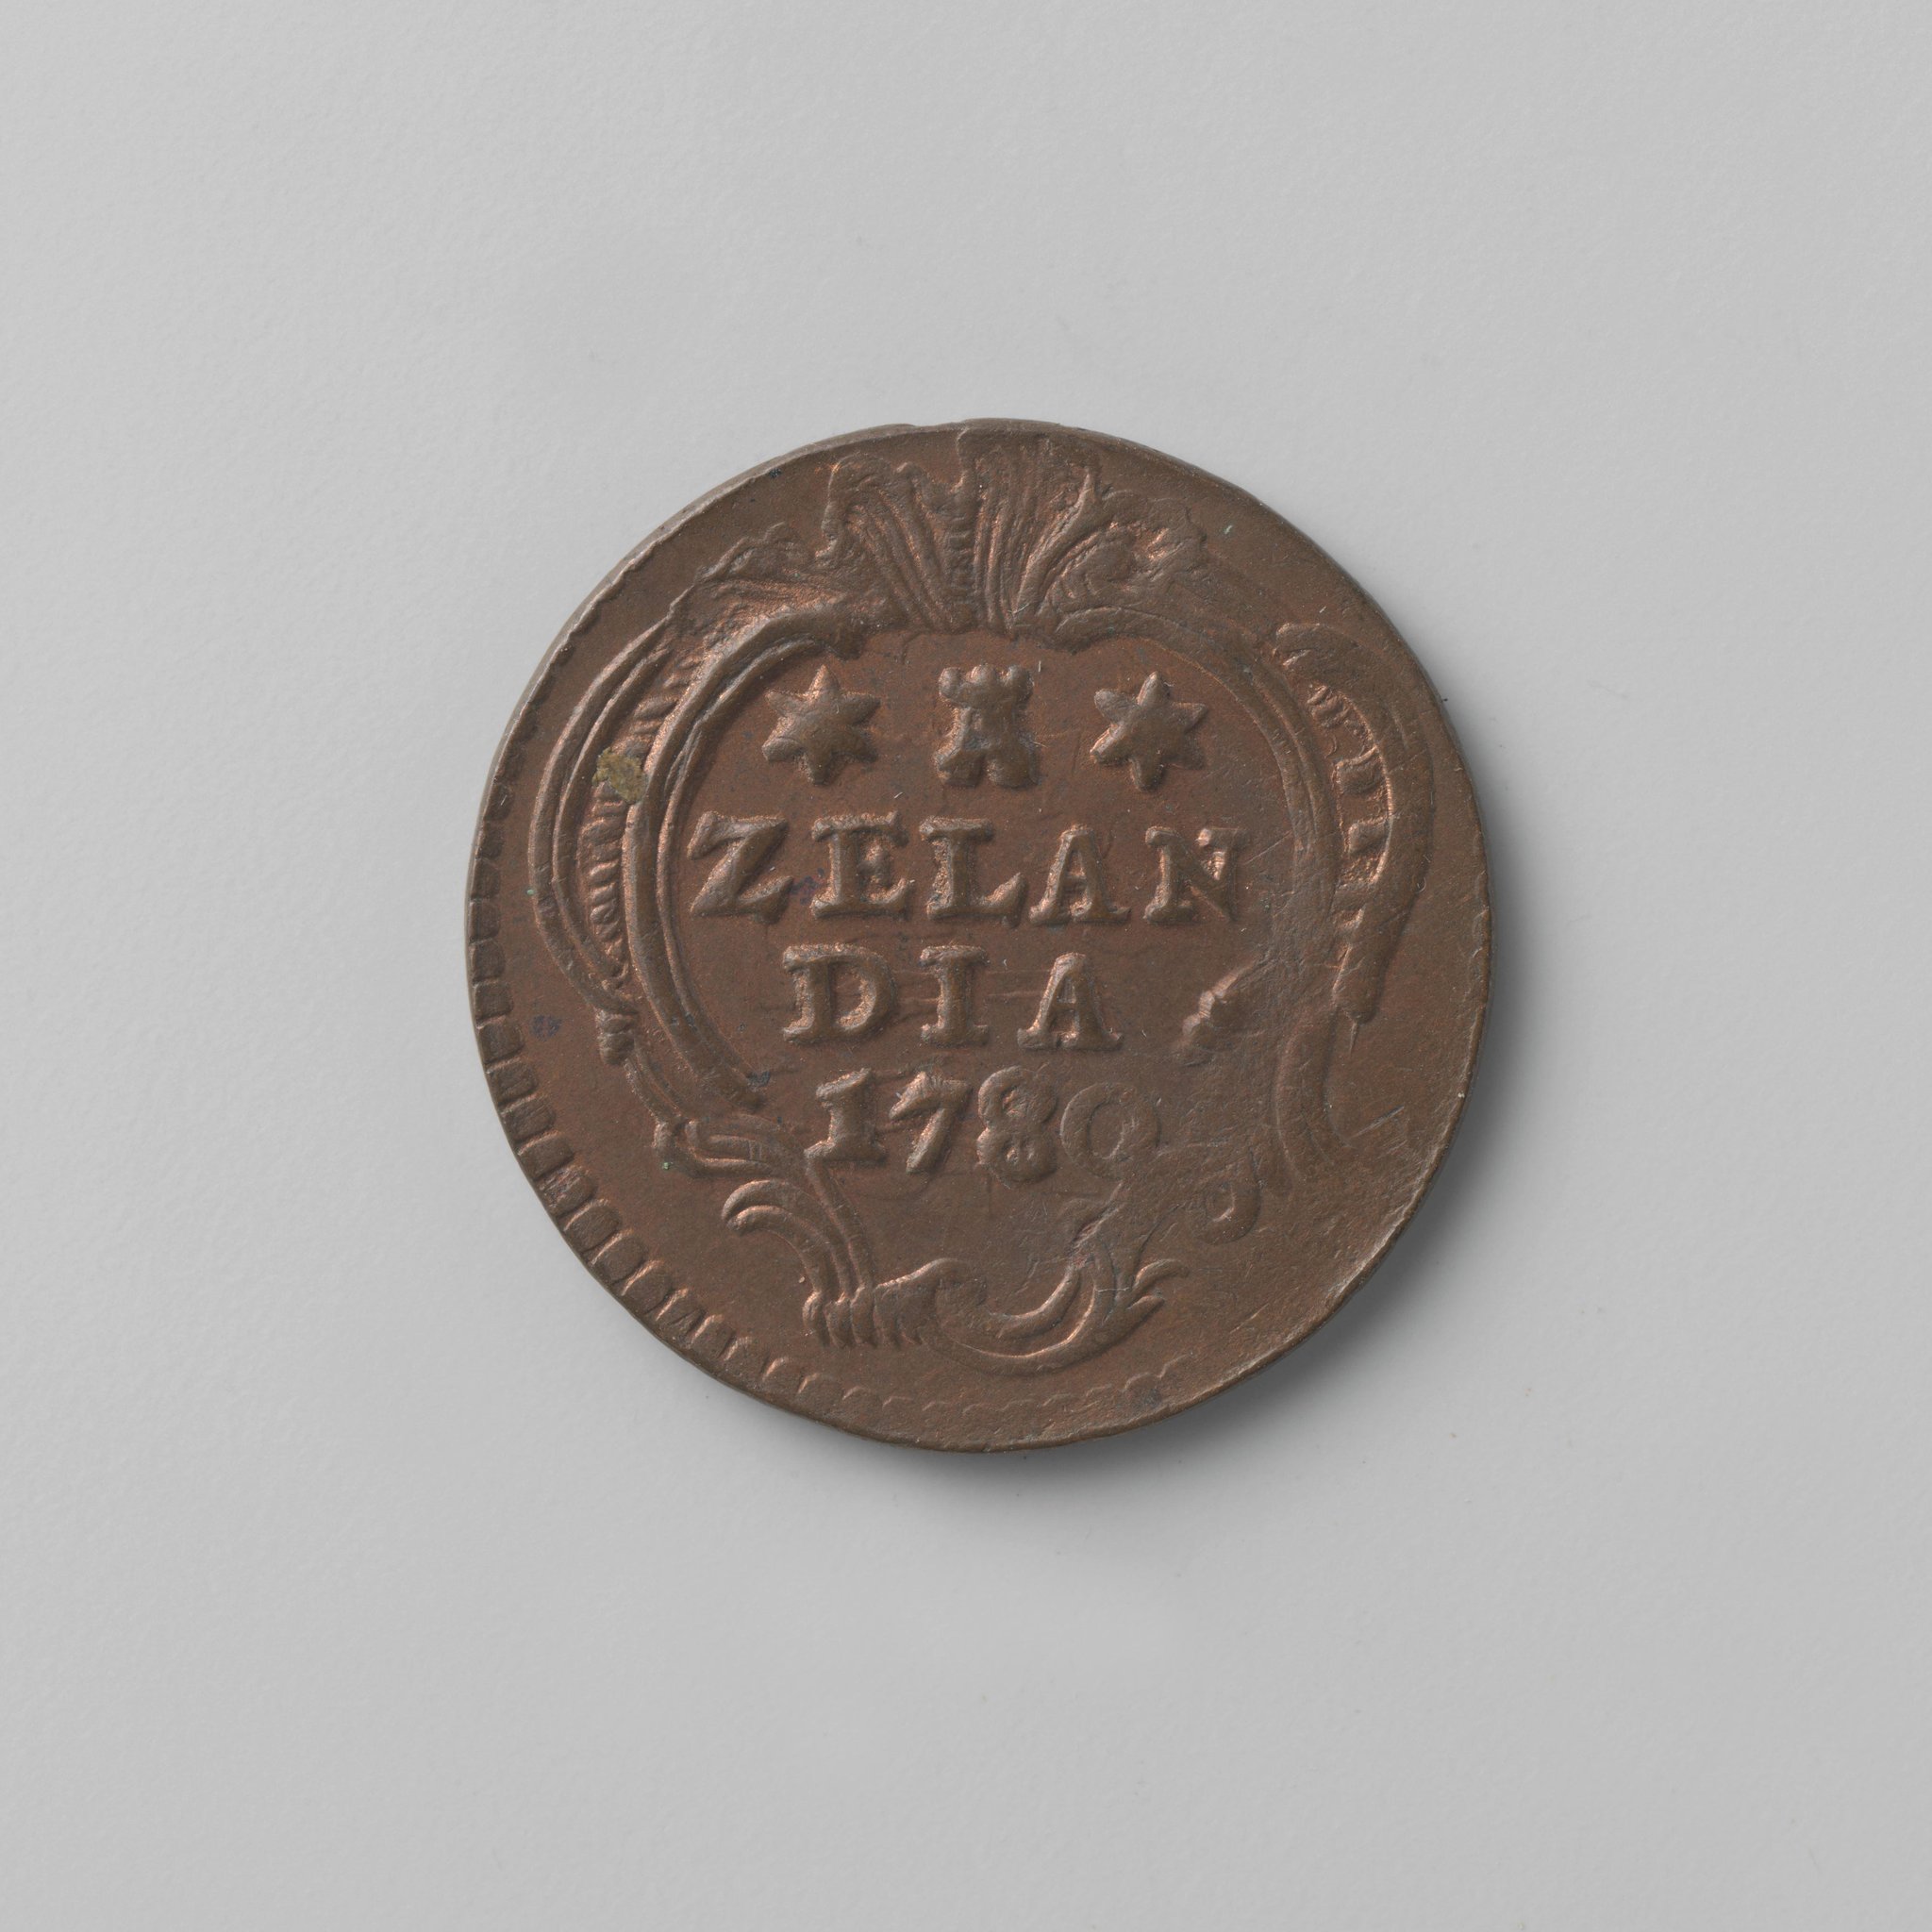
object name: coin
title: Zeeuwse duit, 1780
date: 1780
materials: copper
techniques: striking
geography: middelburg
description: Kopren munt. Voorzijde: in rococo-lijst gekroond ovaal wapenschild van Zeeland. Keerzijde: in een rococo-versiering opschrift in drie regels, waarboven muntteken burcht tussen twee sterren en waaronder jaartal.